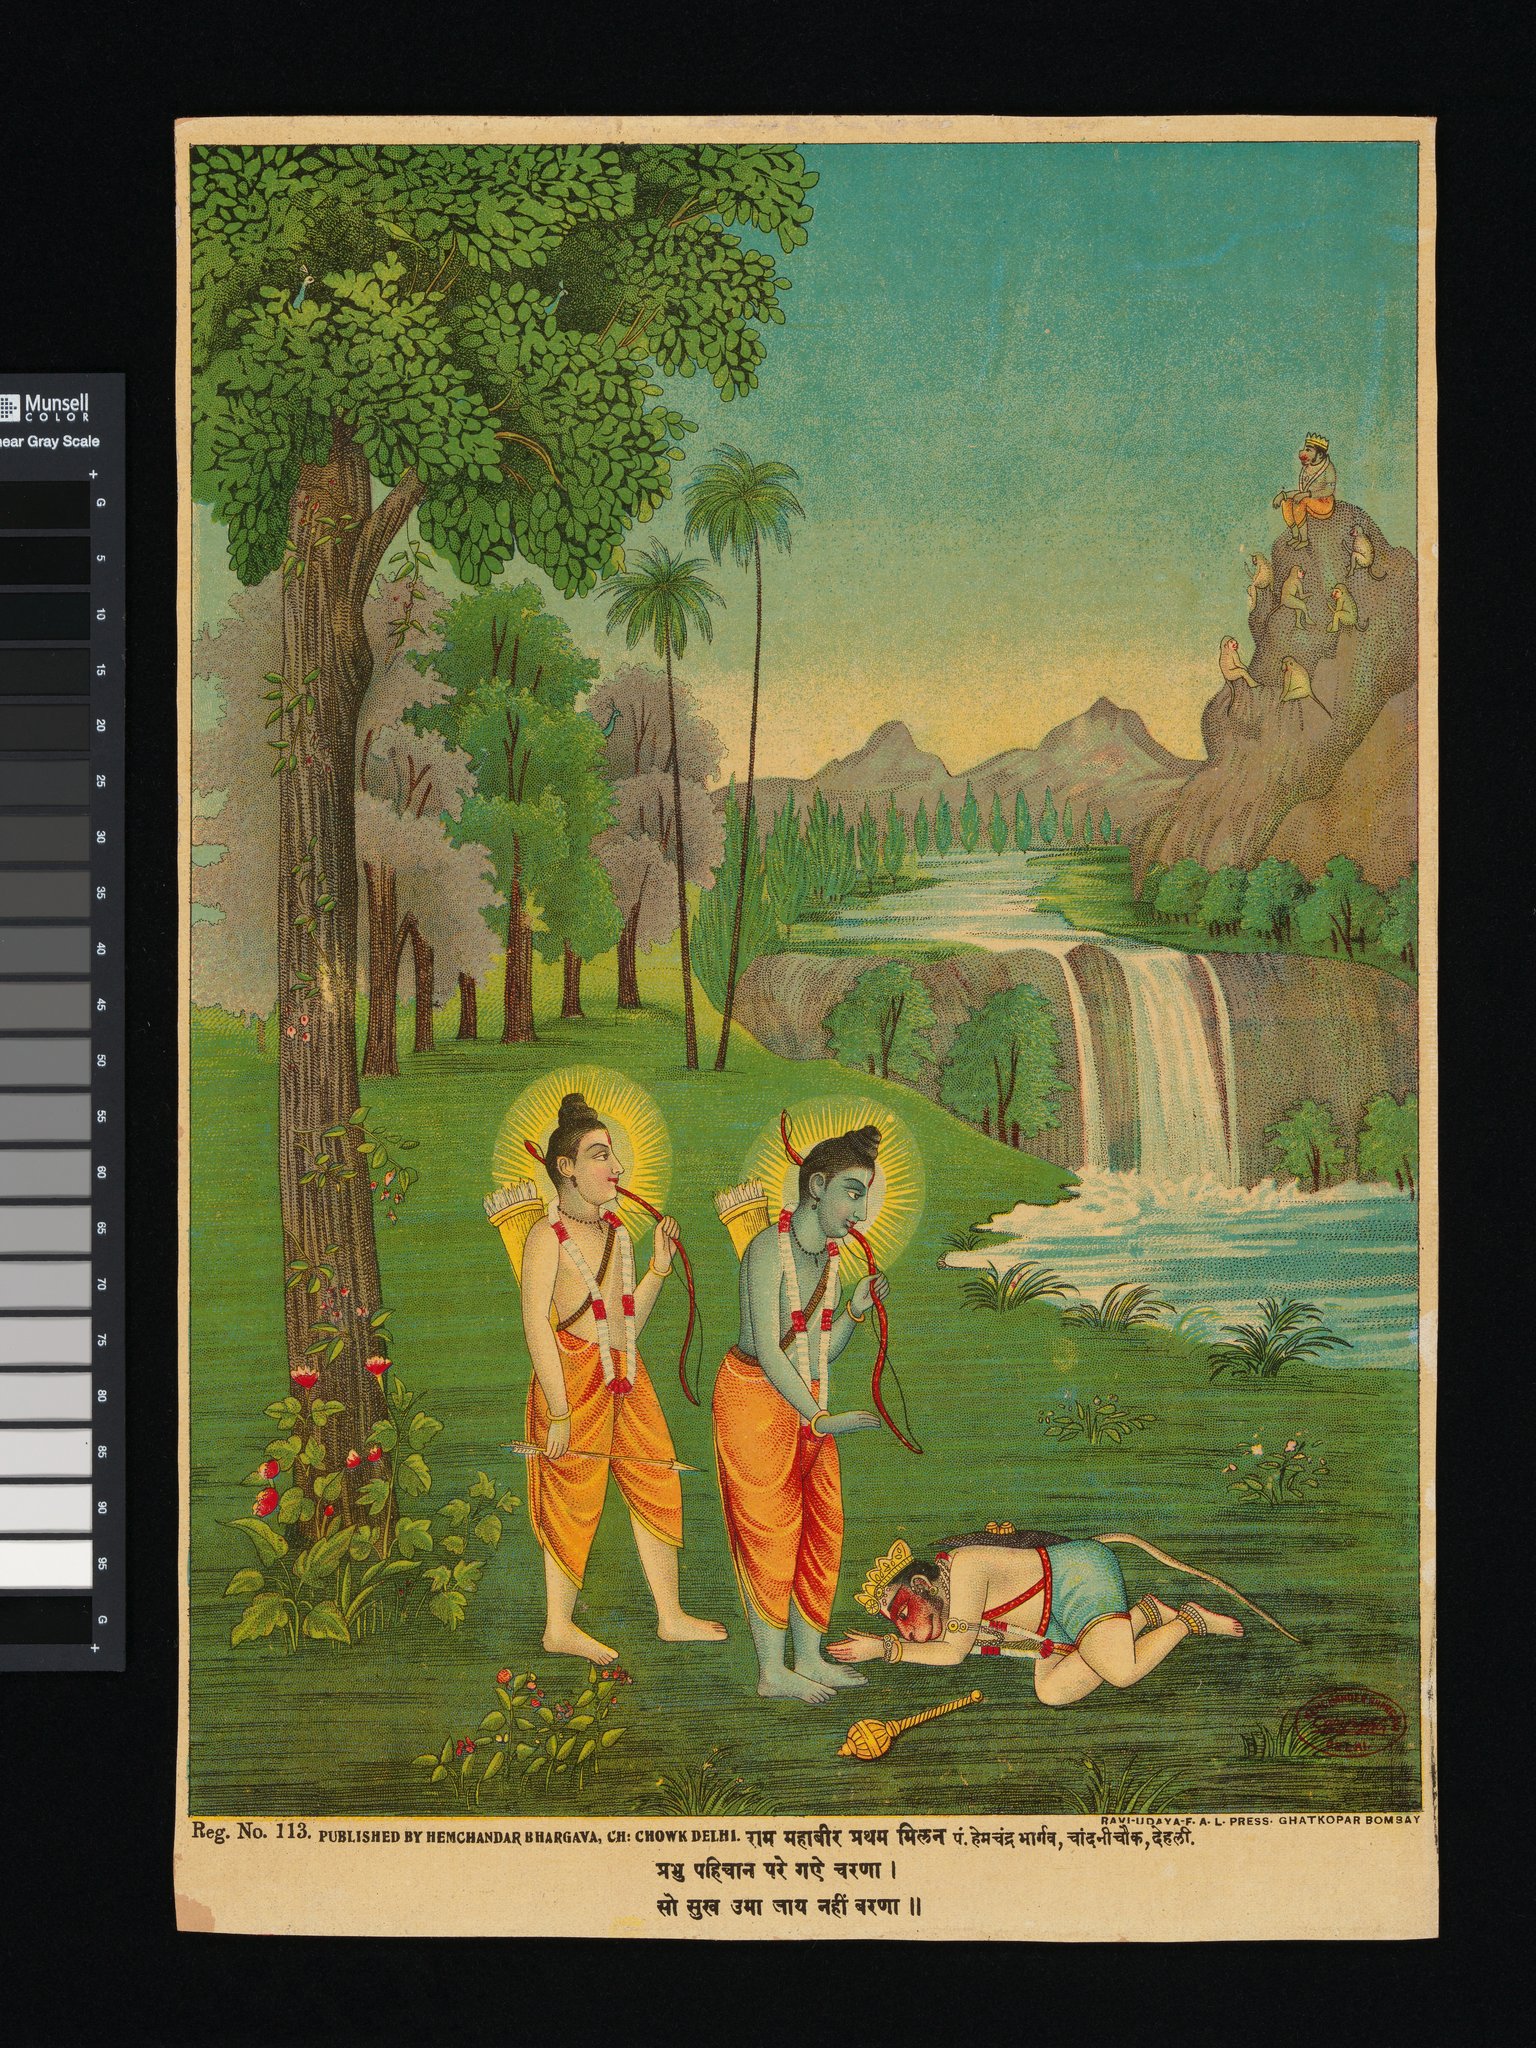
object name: print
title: Rama, Lakshmana, and Hanuman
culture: indian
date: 1910-1915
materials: chromolithograph, paper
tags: men,monkeys